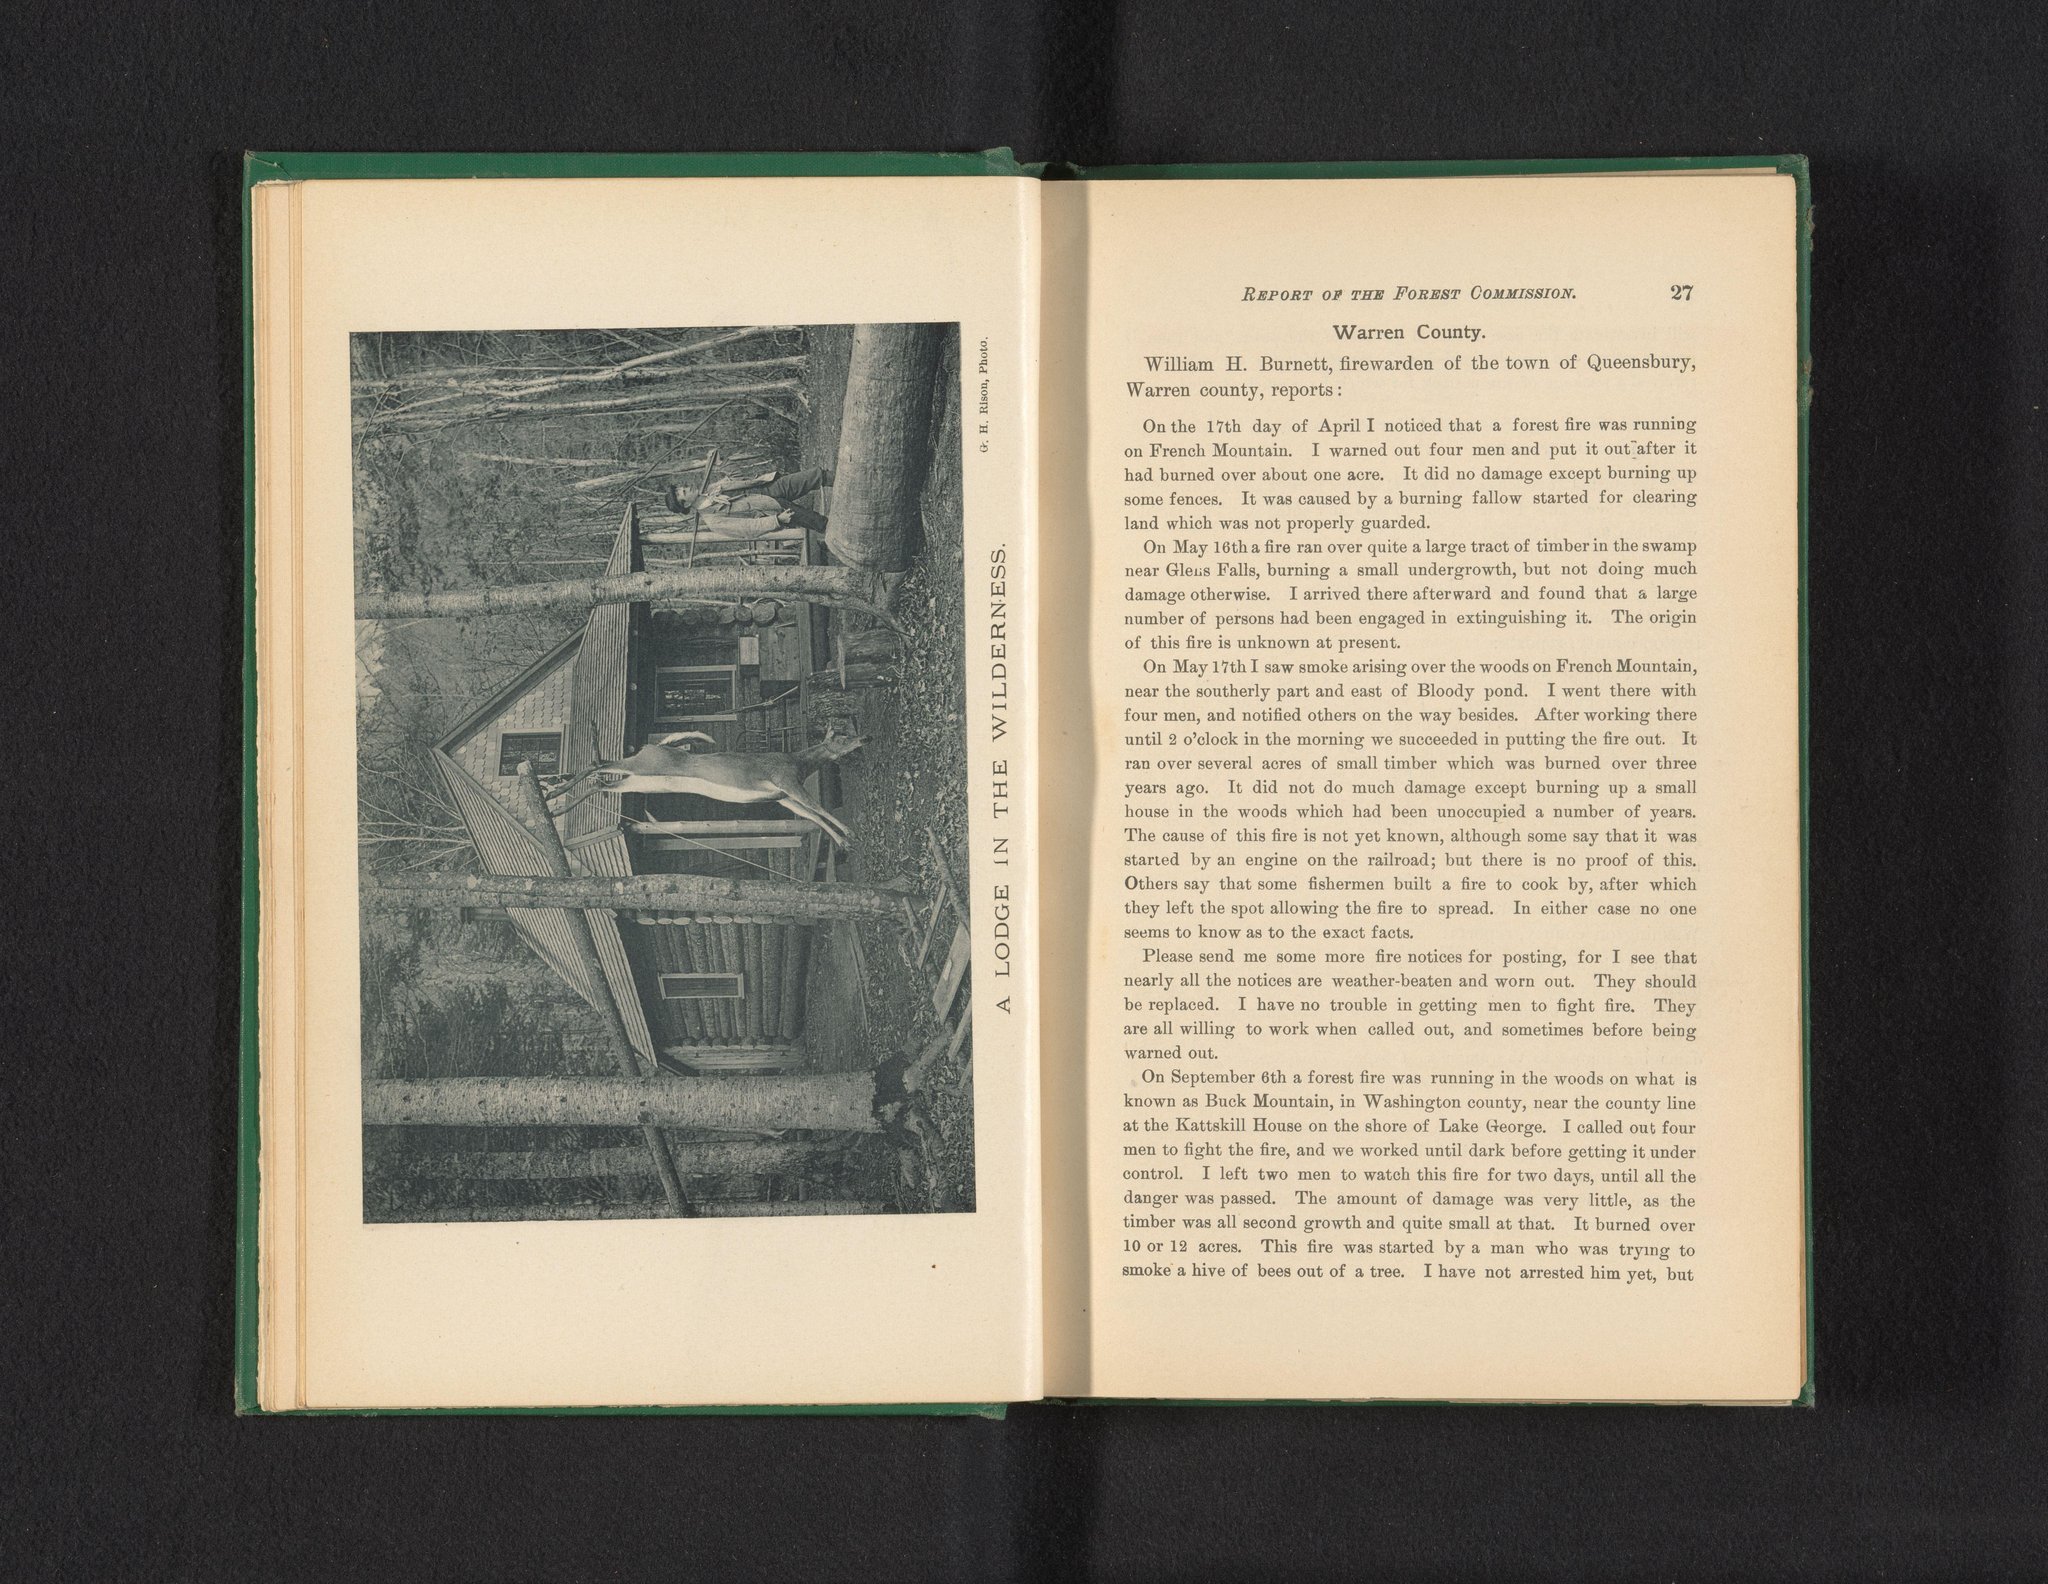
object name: page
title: A lodge in the wilderness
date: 1894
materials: paper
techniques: photograph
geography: new york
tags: hunter displaying or presenting the spoils of the hunt, façade (of house or building), hut, cabin, lodge